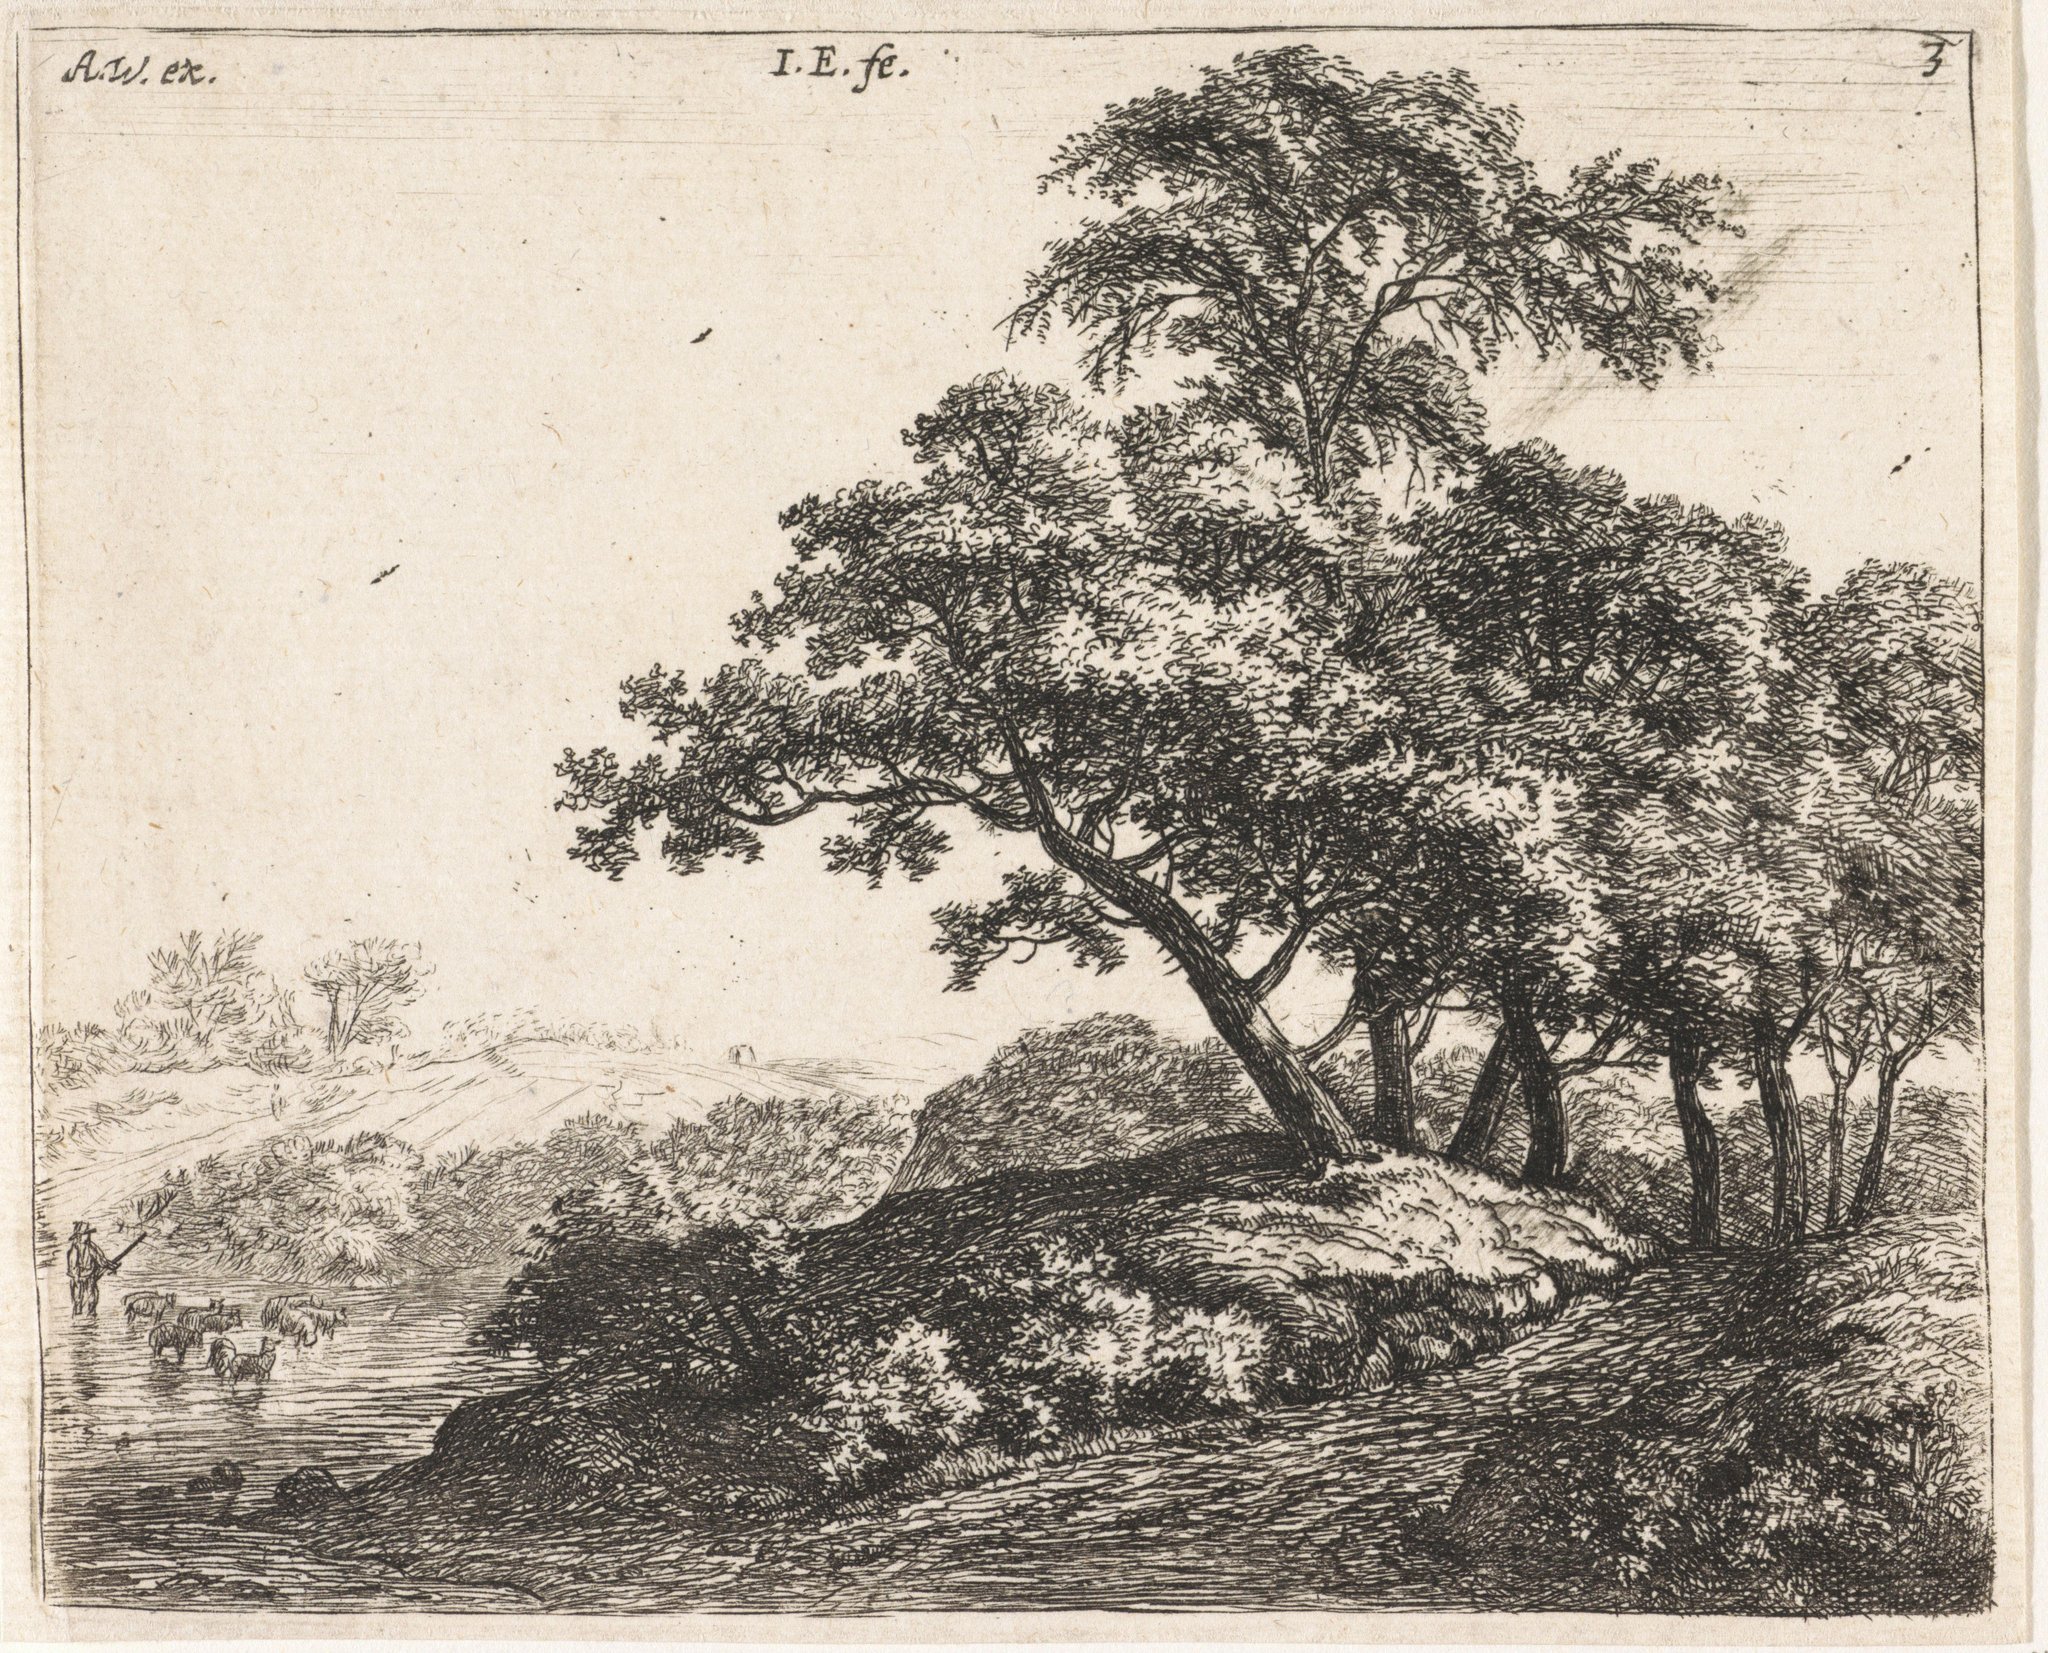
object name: print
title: Kudde schapen in een rivier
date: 1646-1663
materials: paper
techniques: etching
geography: amsterdam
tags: river, herding, herdsman, herdswoman, shepherd, shepherdess, cowherd, etc., forest, wood, sheep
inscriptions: collector's mark: Lugt 2228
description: Rechts een bospad door een glooiend landschap. Links in de verte waadt een herder met zijn kudde schapen door een rivier.